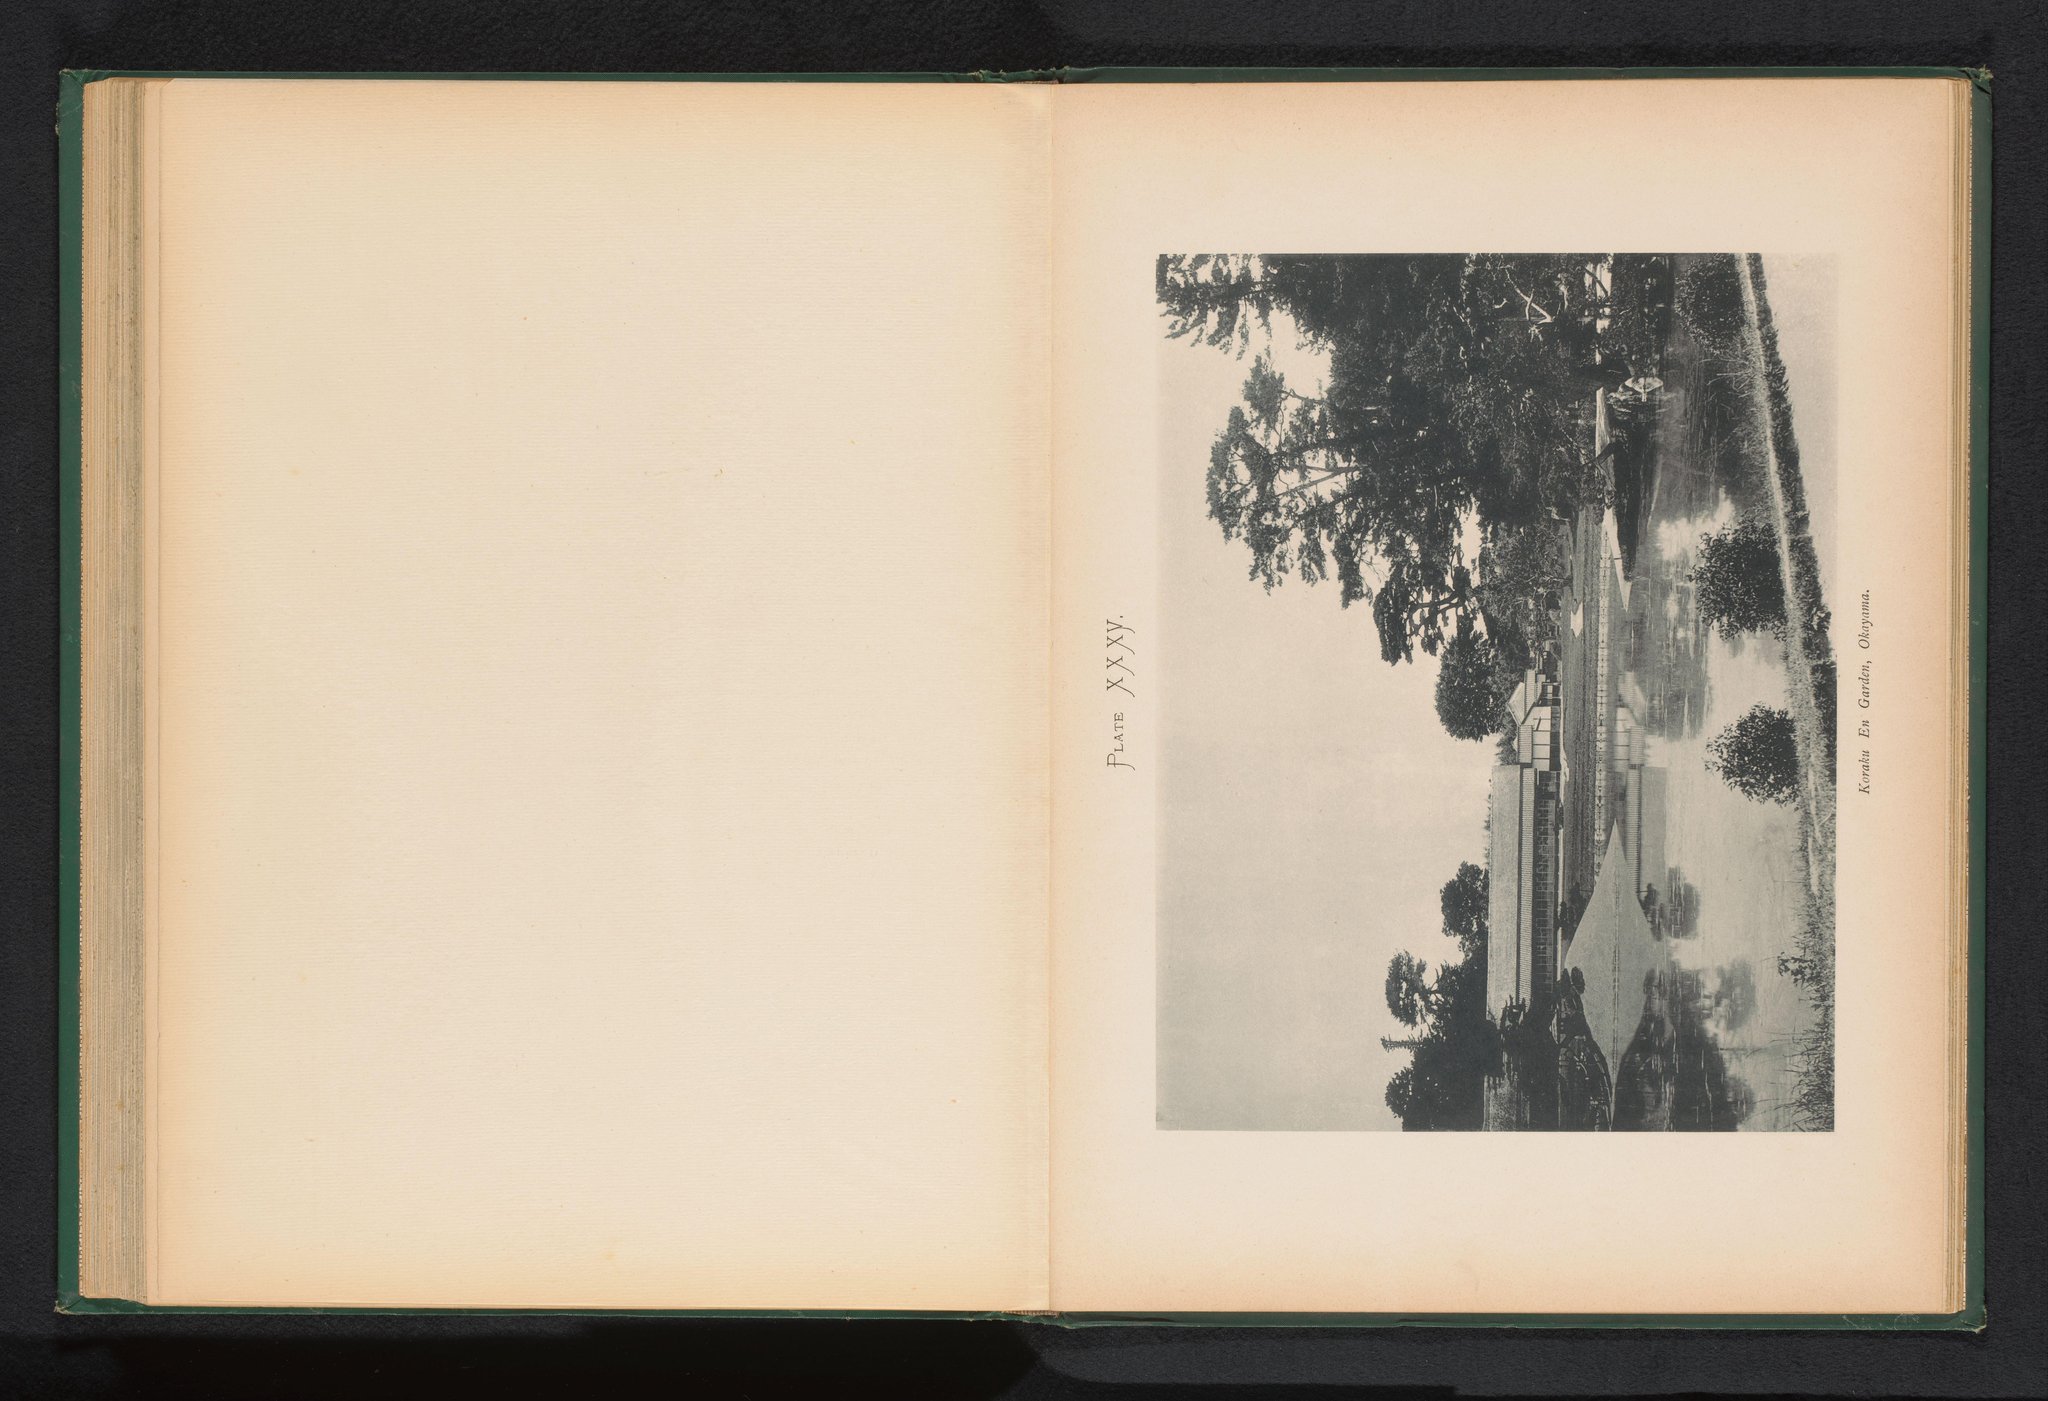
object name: page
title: Gezicht op de Koraku-en tuinen in Okayama, Japan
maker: kazumasa ogawa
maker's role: auteur, fotograaf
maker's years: 1860-1929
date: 1888-1893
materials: paper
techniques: photograph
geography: okayama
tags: garden, pond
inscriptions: inscription: ‘Plate XXXV.’